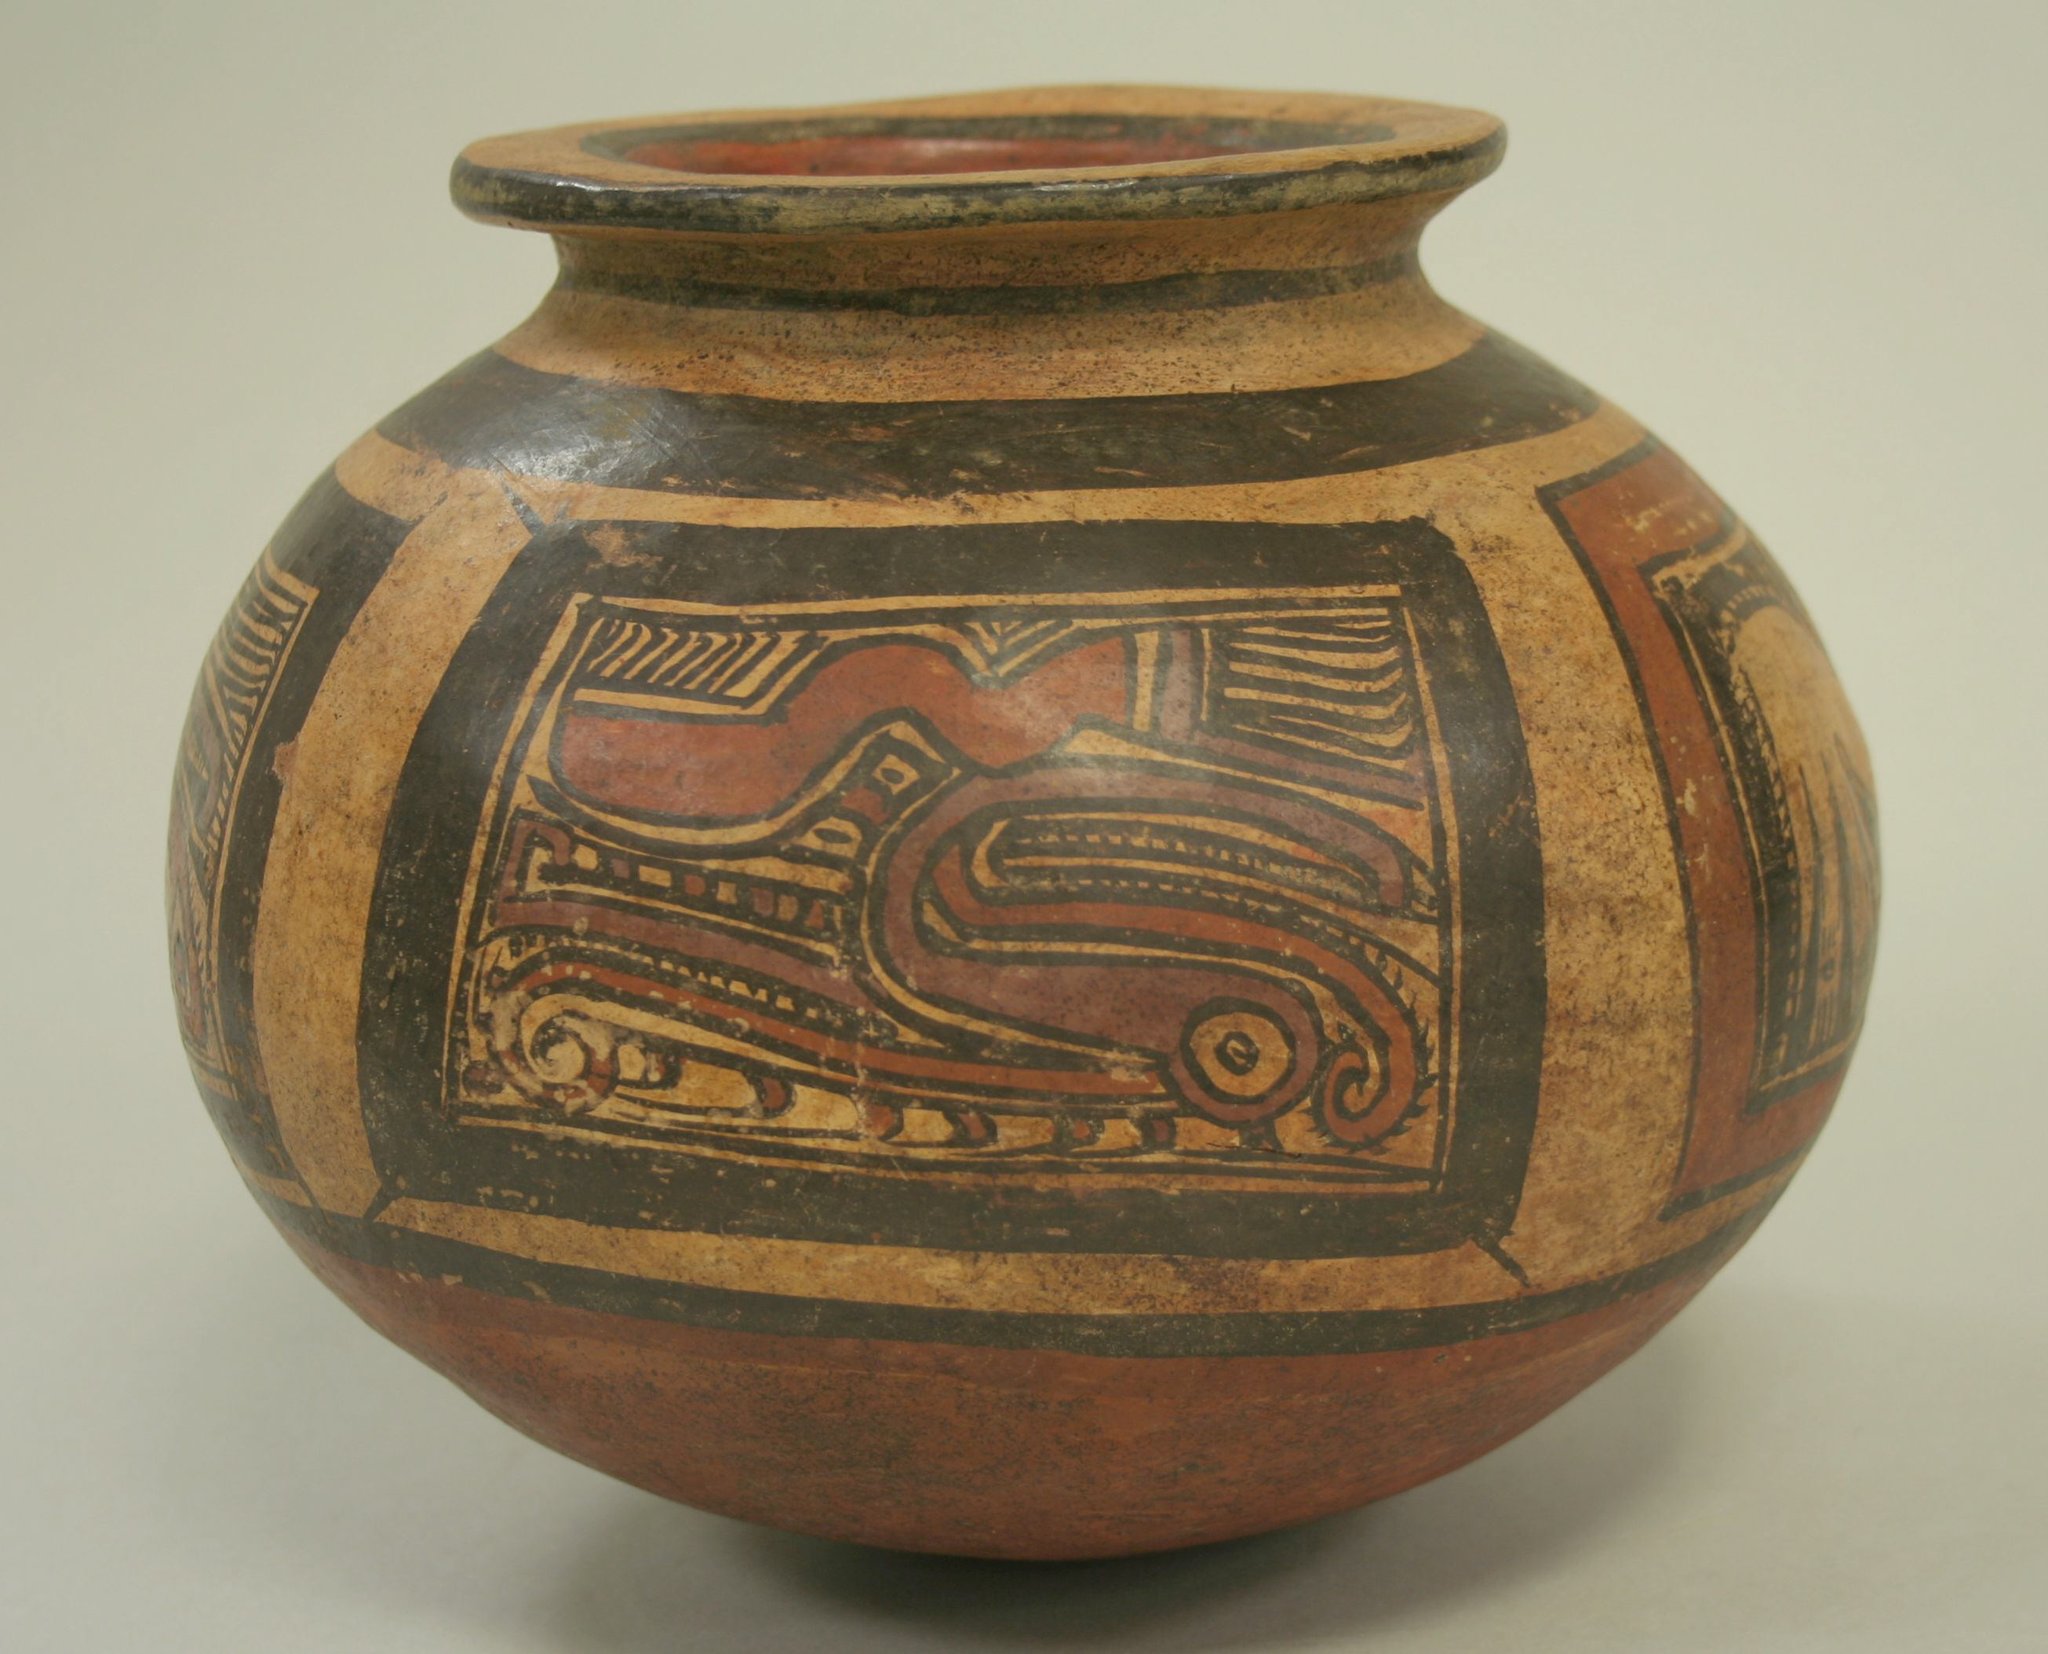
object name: vessel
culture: panamanian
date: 501-1100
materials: ceramic, pigment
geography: panama